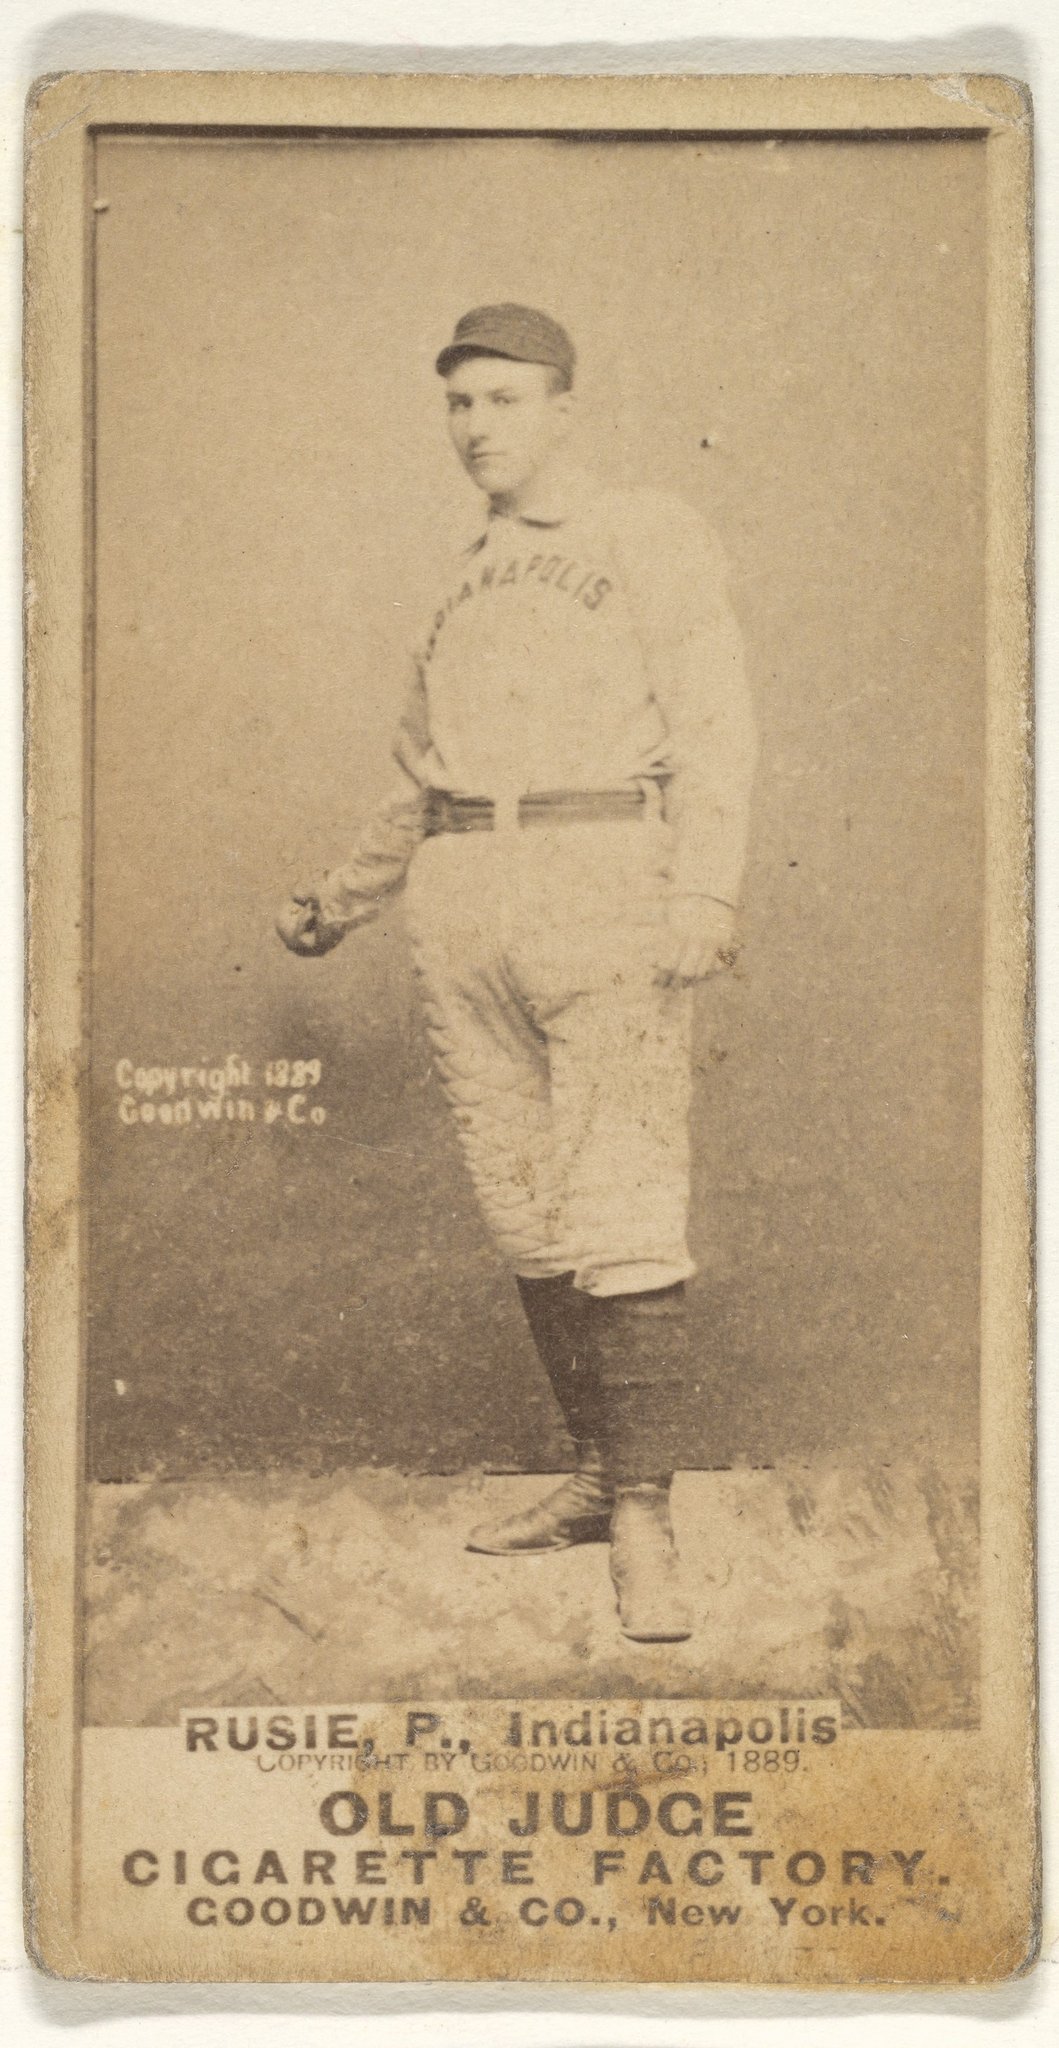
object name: baseball card, photograph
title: Amos Rusie, Pitcher, Indianapolis, from the Old Judge series (N172) for Old Judge Cigarettes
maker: goodwin & company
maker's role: publisher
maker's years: 1850-1950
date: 1889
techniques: albumen silver print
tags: men,portraits,baseball,athletes